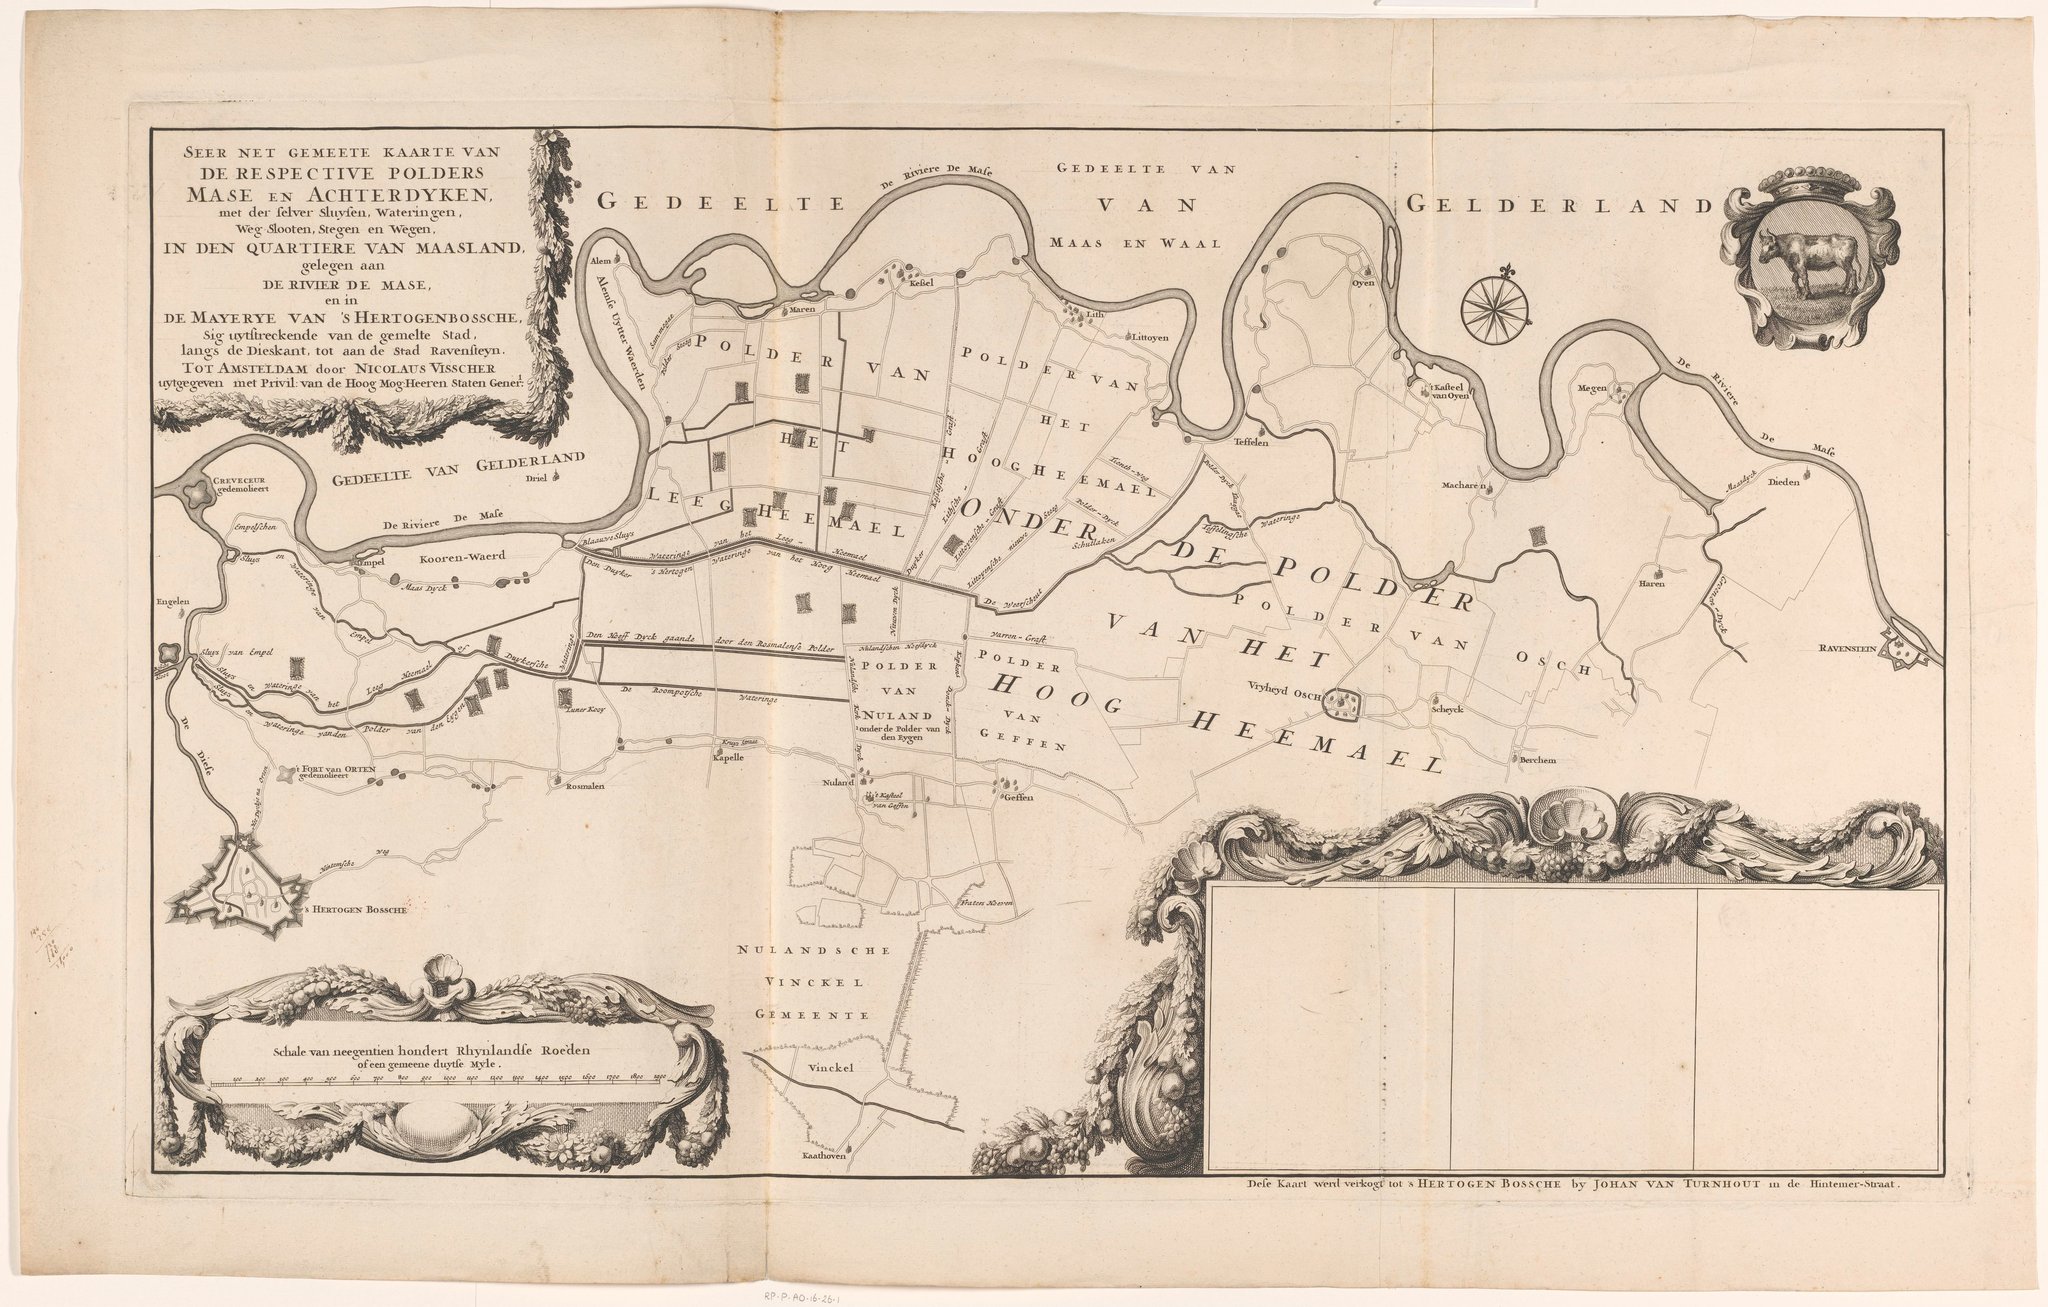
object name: print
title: Seer net gemeete kaarte van de respective polders Mase en Achterdyken (...) in den quartiere van Maasland (...)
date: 1677-1720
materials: paper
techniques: engraving, etching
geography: den bosch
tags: maps of separate countries or regions, polder, reclaimed land, coat of arms (as symbol of the state, etc.) (+ province; provincial), den bosch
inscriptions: collector's mark: Lugt 195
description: Kaart van de polders in het Kwartier van Maasland. Linksboven de titelcartouche. Rechtsboven het wapen van het Kwartier van Maasland. Linksonder een cartouche met schaalstok: Schale van neegentien hondert Rhynlandse Roeden of een gemeene duytse Myle. Rechtsonder een lege cartouche.